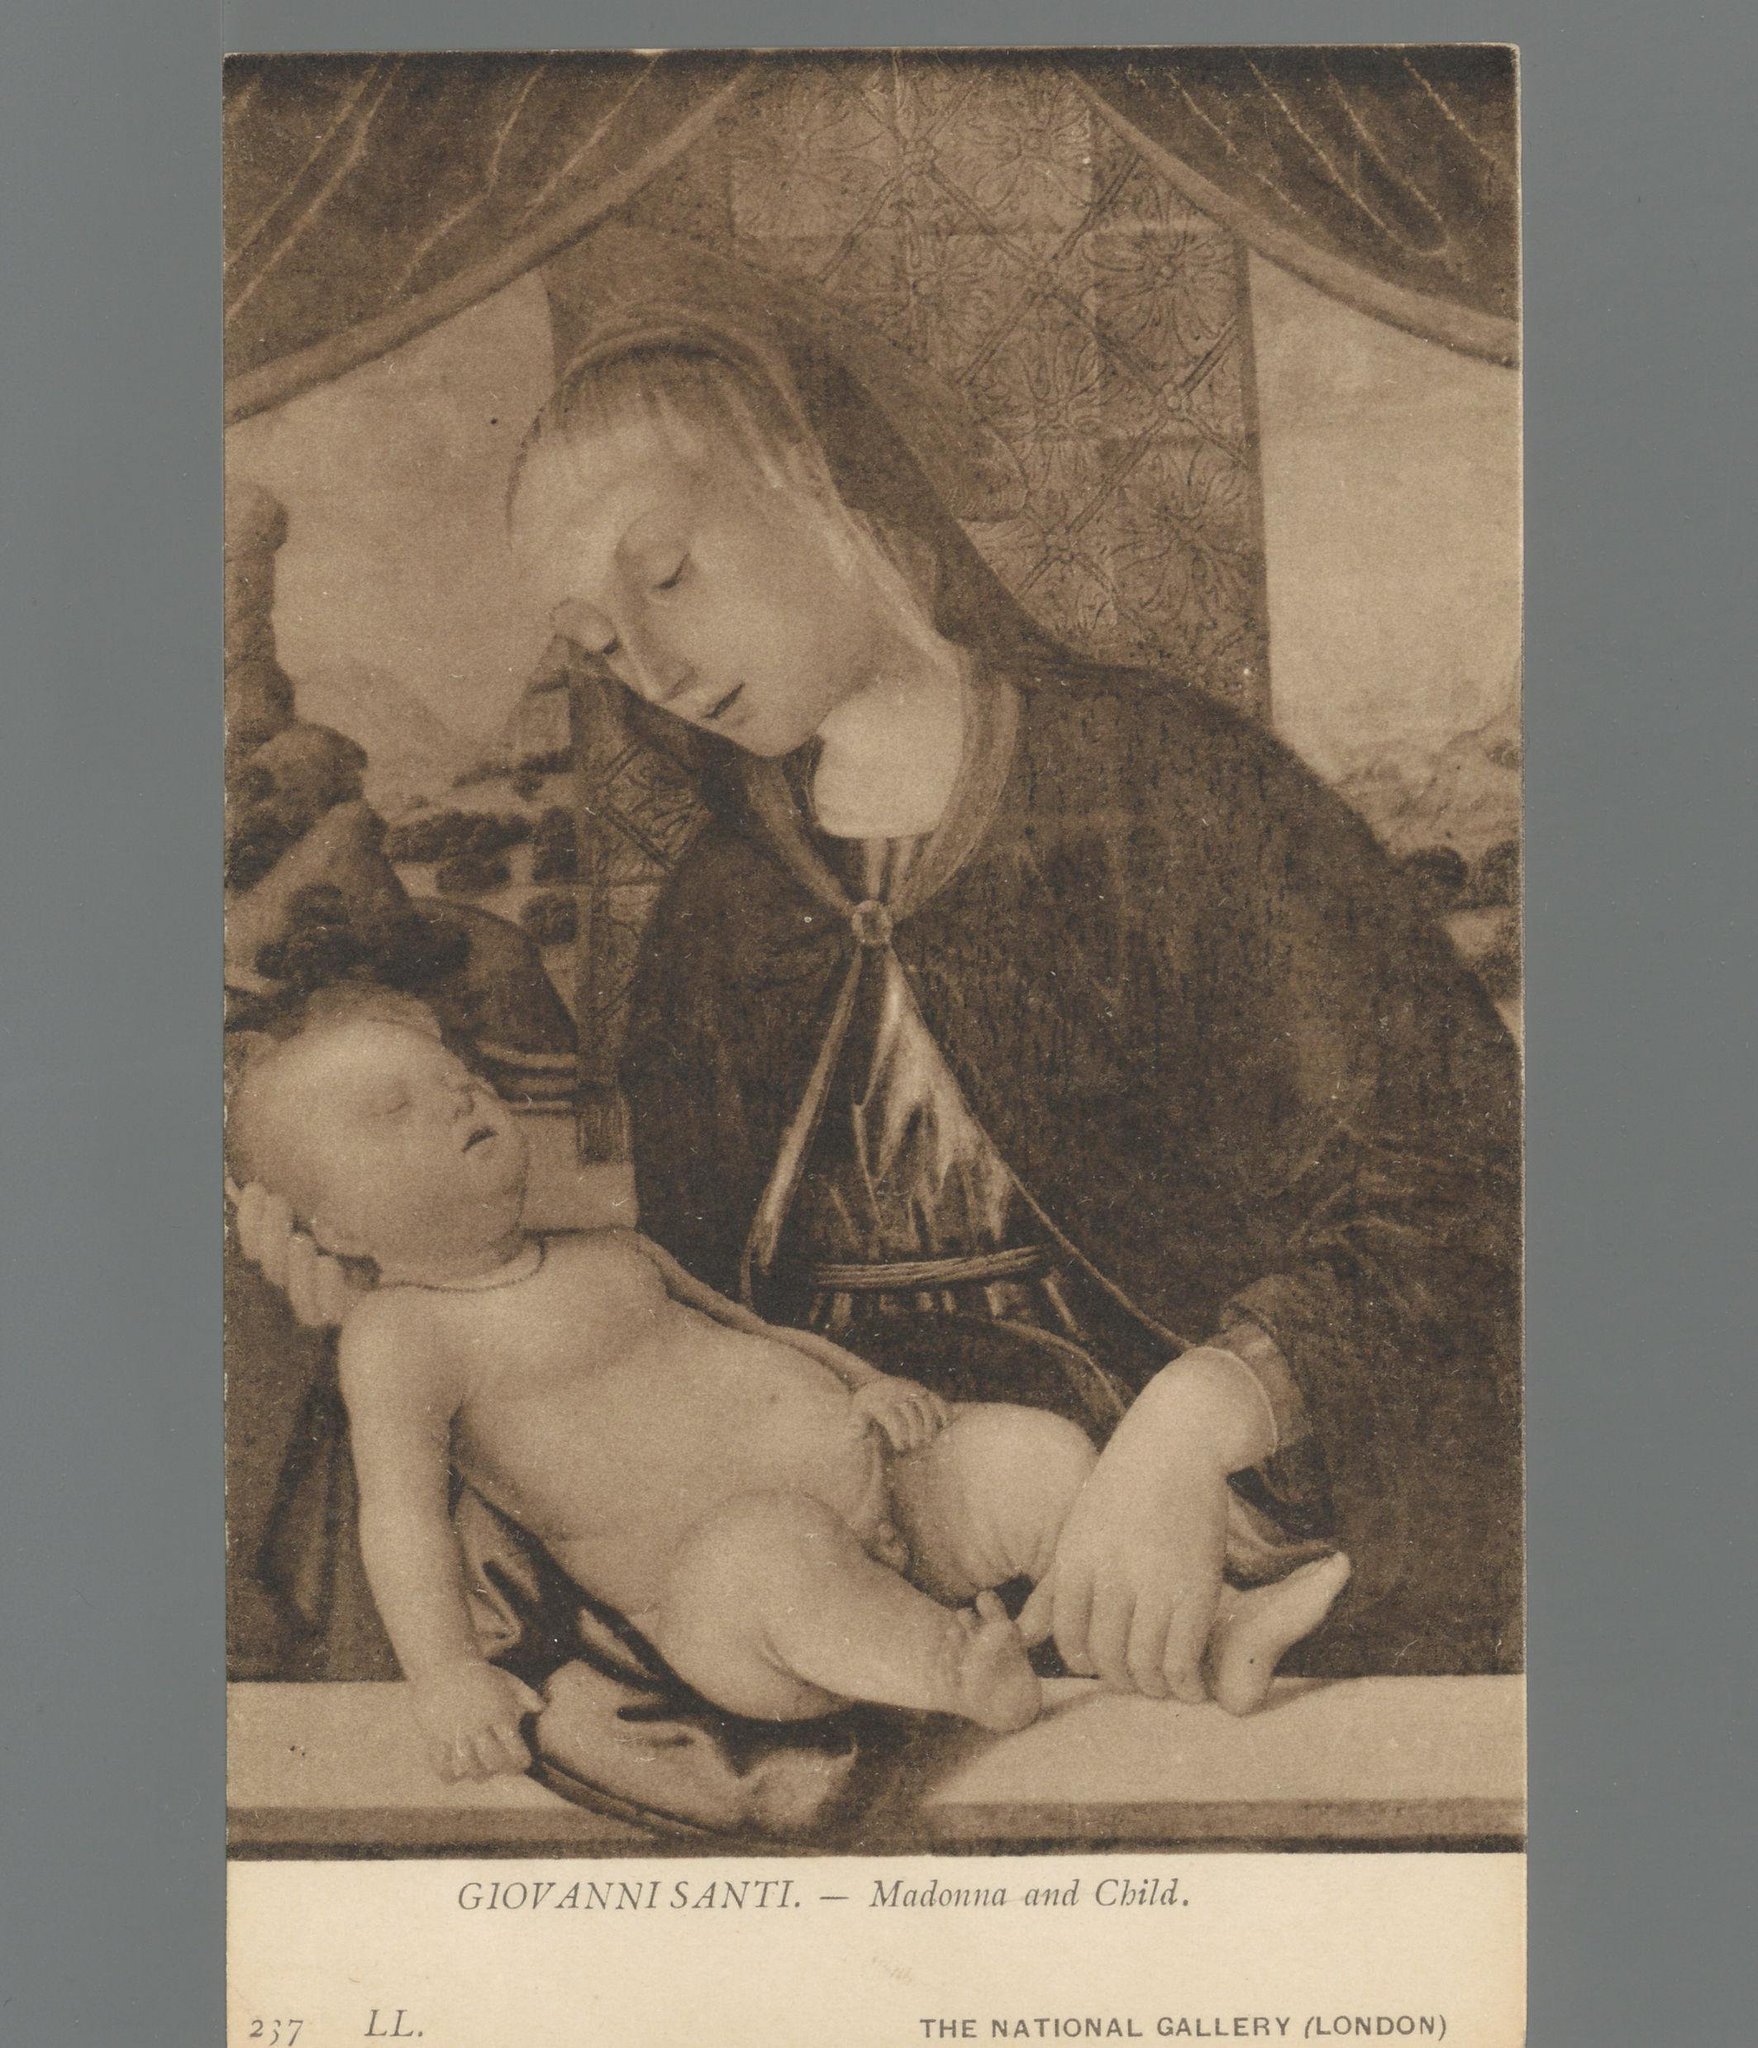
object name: reproduction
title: Giovanni Santi.- Madonna and child. The National Gallery (London)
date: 1903-1930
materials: cardboard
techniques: photograph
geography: paris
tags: series of scenes from the life of mary, permanent exhibition, museum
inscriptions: collector's mark: ‘AFE v S’